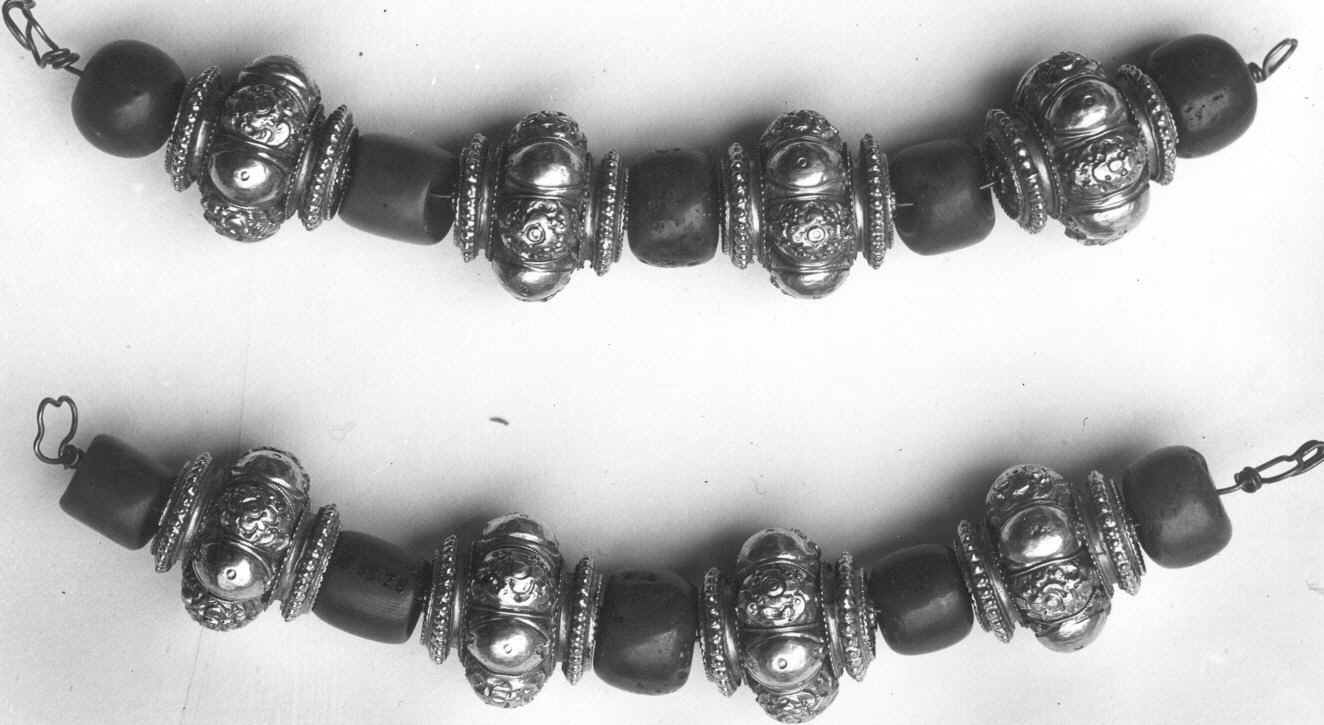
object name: bracelet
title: Bracelet, One of a Pair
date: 1701-1900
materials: gold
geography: southern india